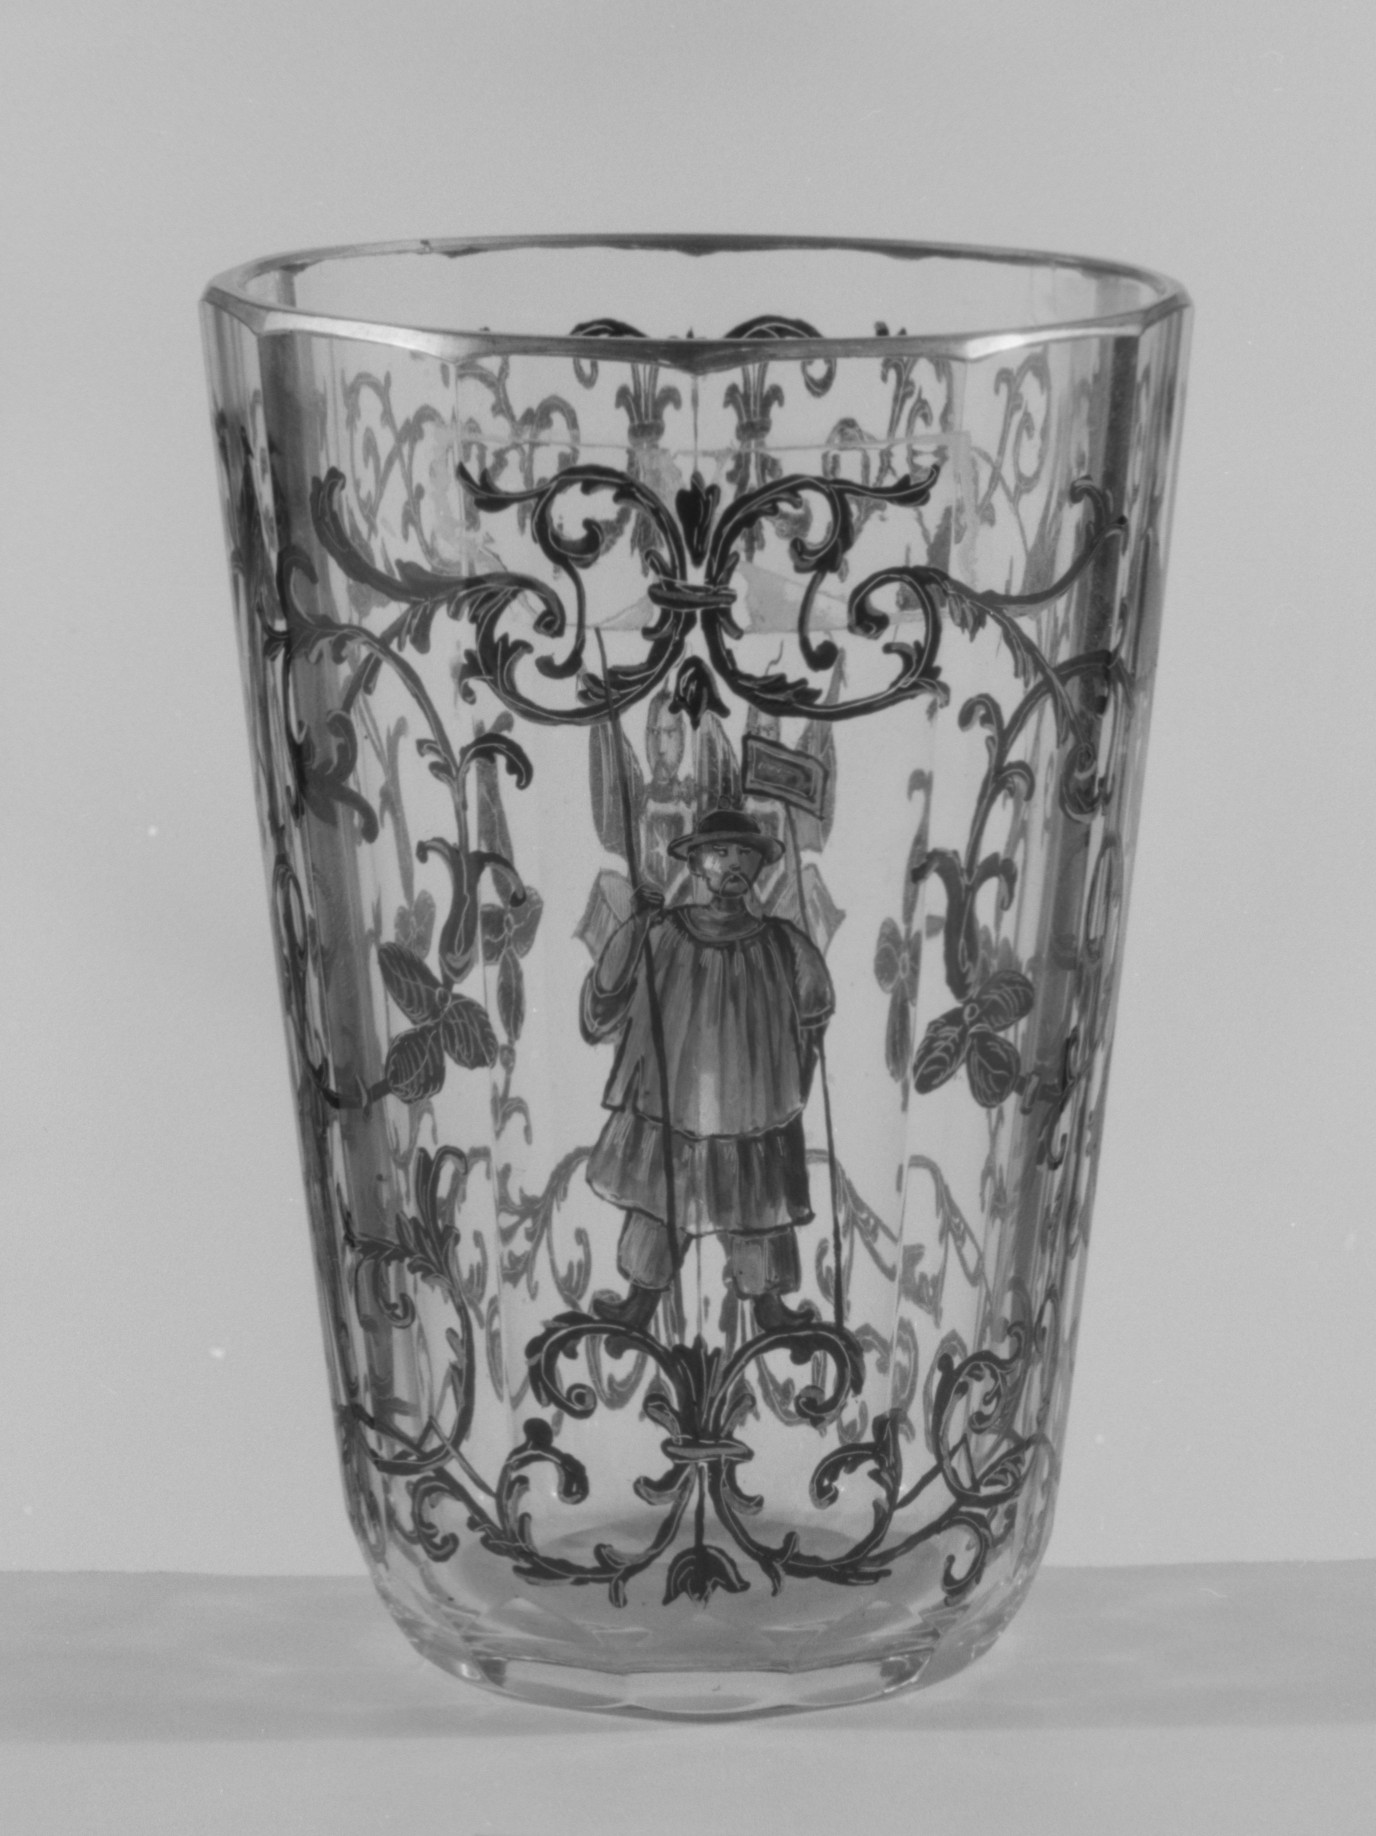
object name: tumbler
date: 1726-1750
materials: glass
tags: men